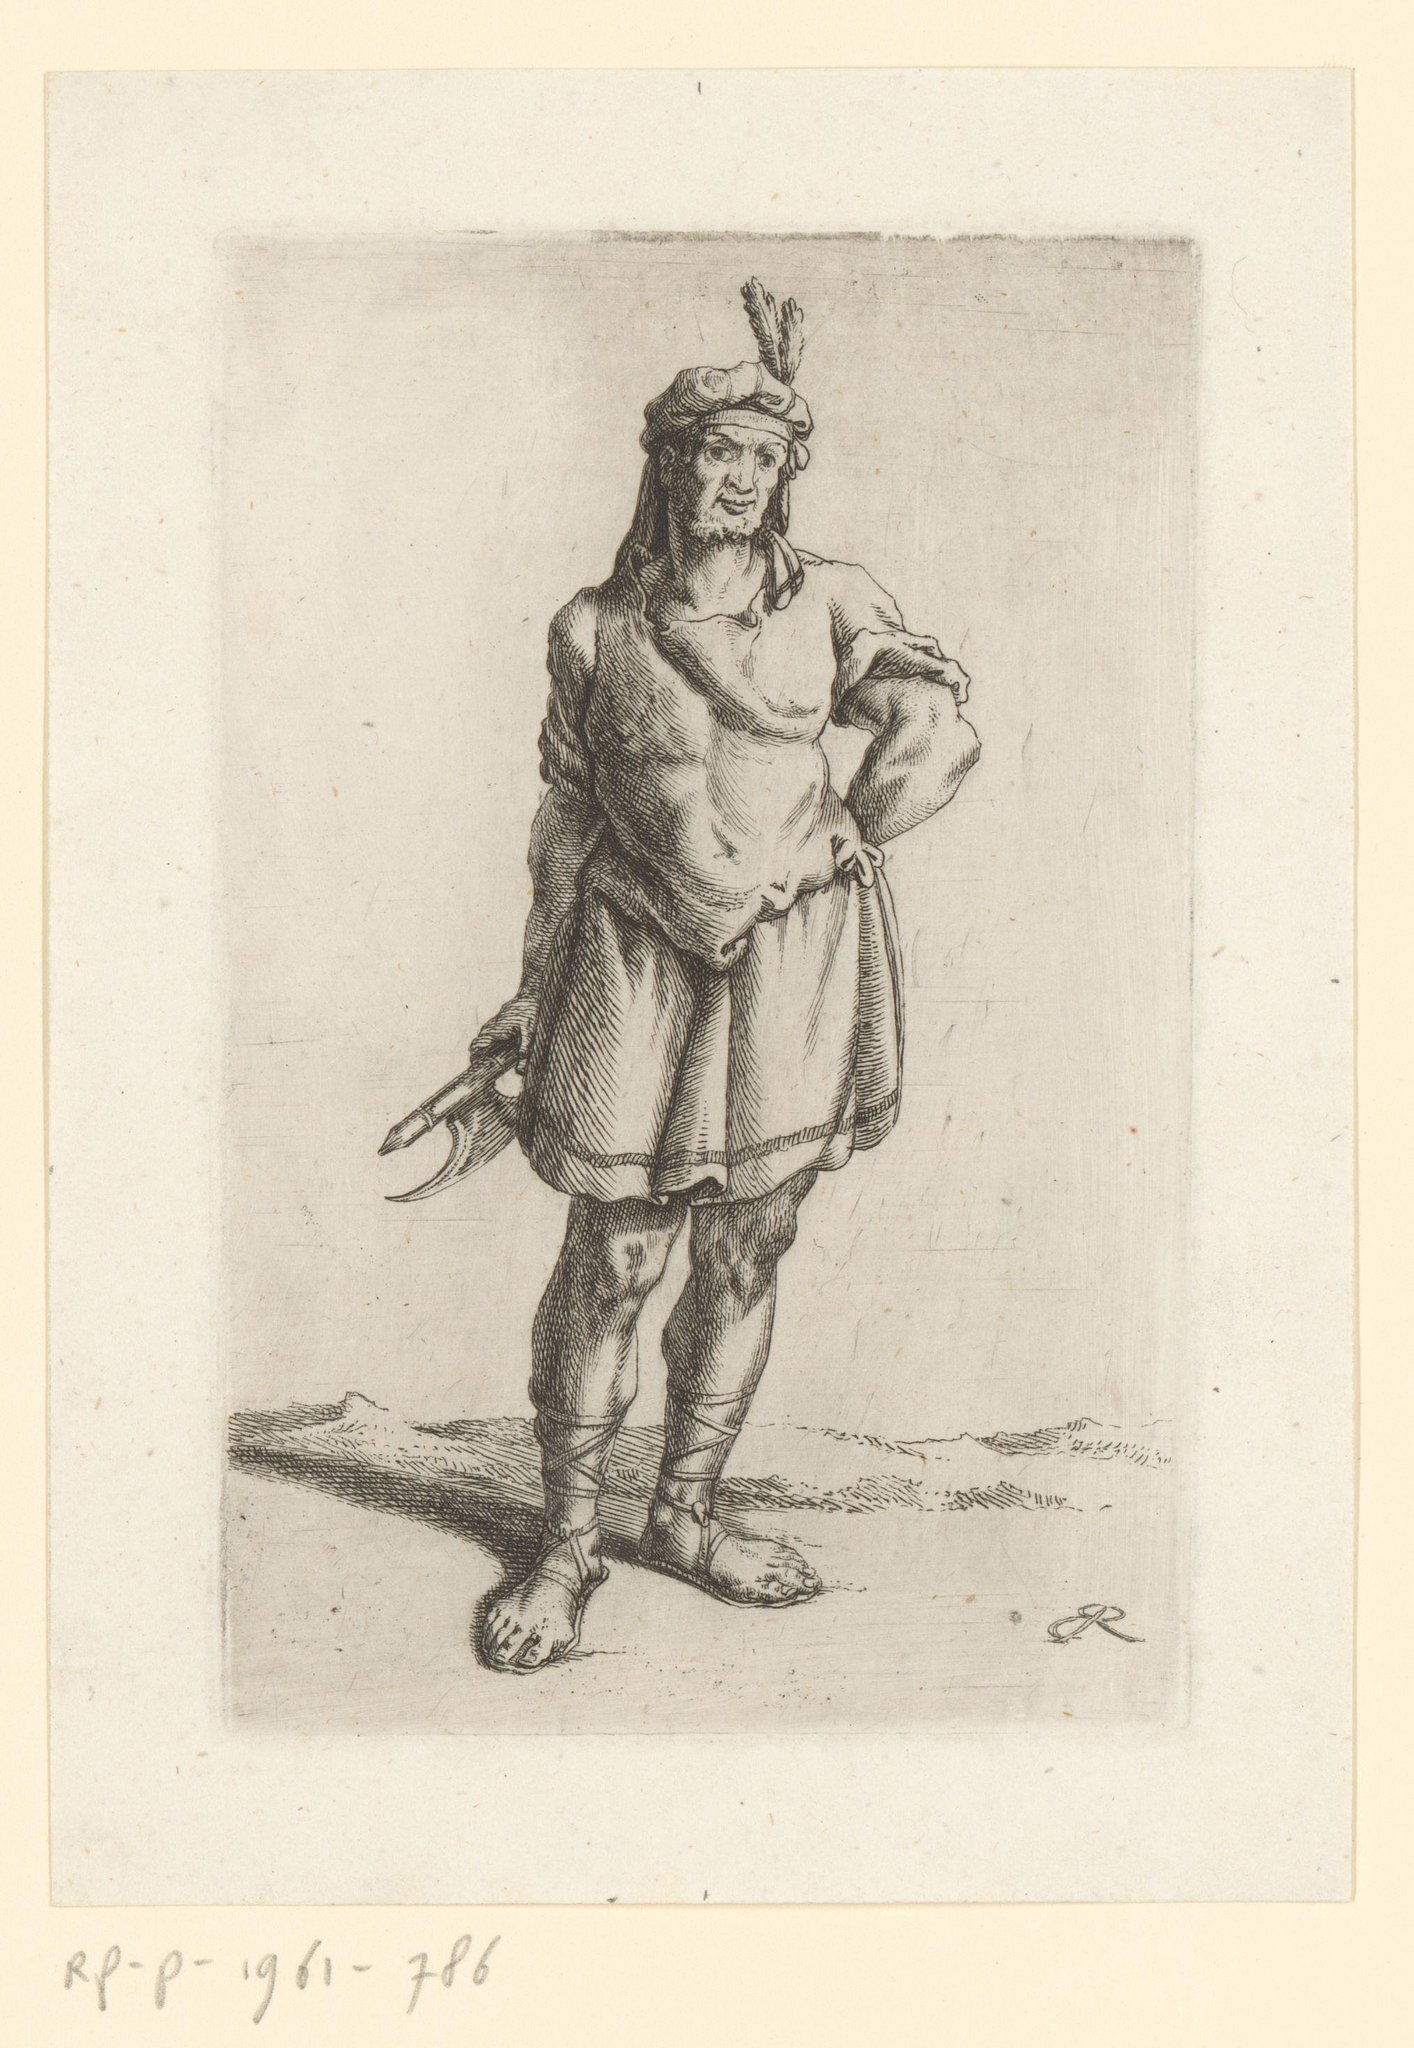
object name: print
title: Staande krijgsman met bijl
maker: johann elias ridinger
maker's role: draughtsman, painter, print maker, publisher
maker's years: 1698-1767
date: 1728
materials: paper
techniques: etching, intaglio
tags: tools, aids, implements ~ crafts and industries: axe, the soldier; the soldier's life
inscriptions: collector's mark: Lugt 2228